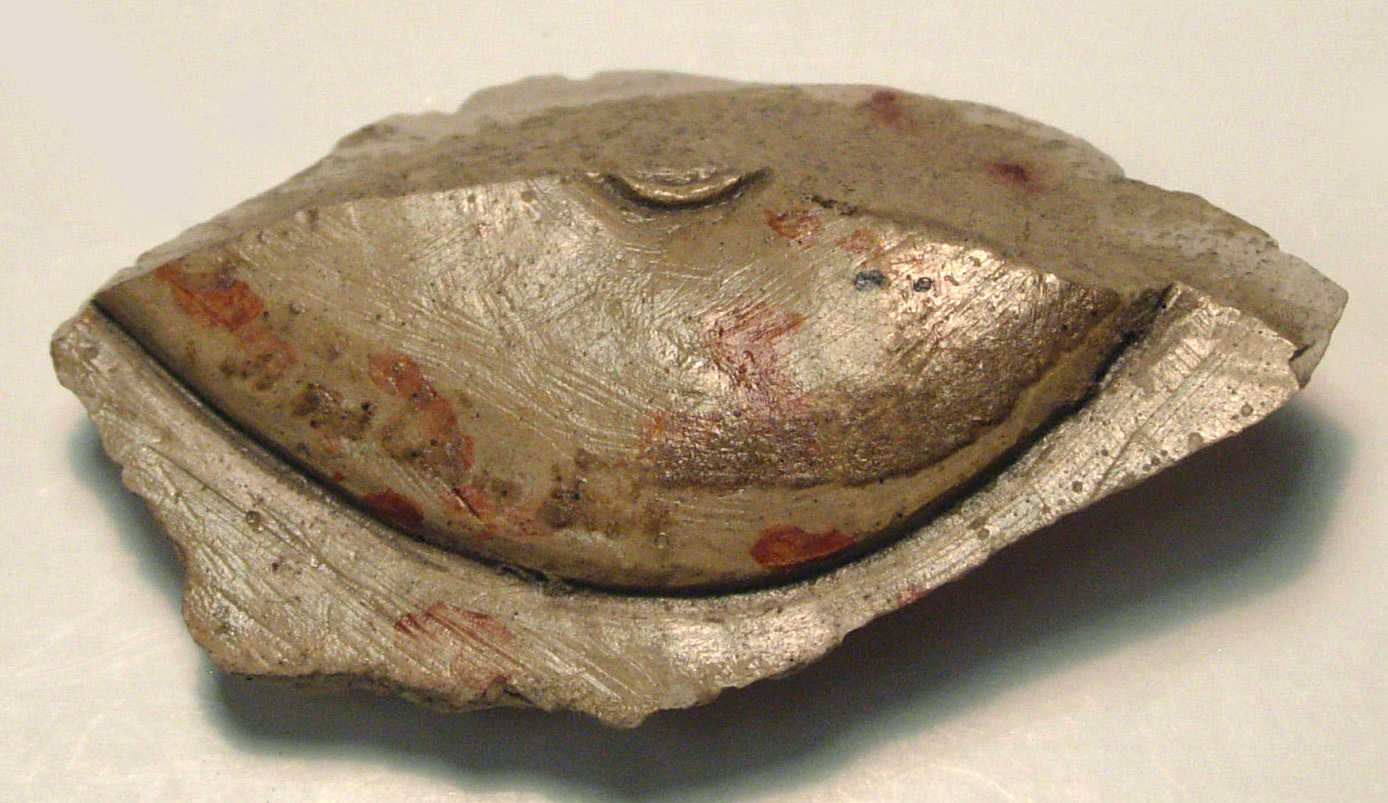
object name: relief, tomb of nespekashuty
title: Raised relief fragment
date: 664-610 BCE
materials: limestone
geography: egypt